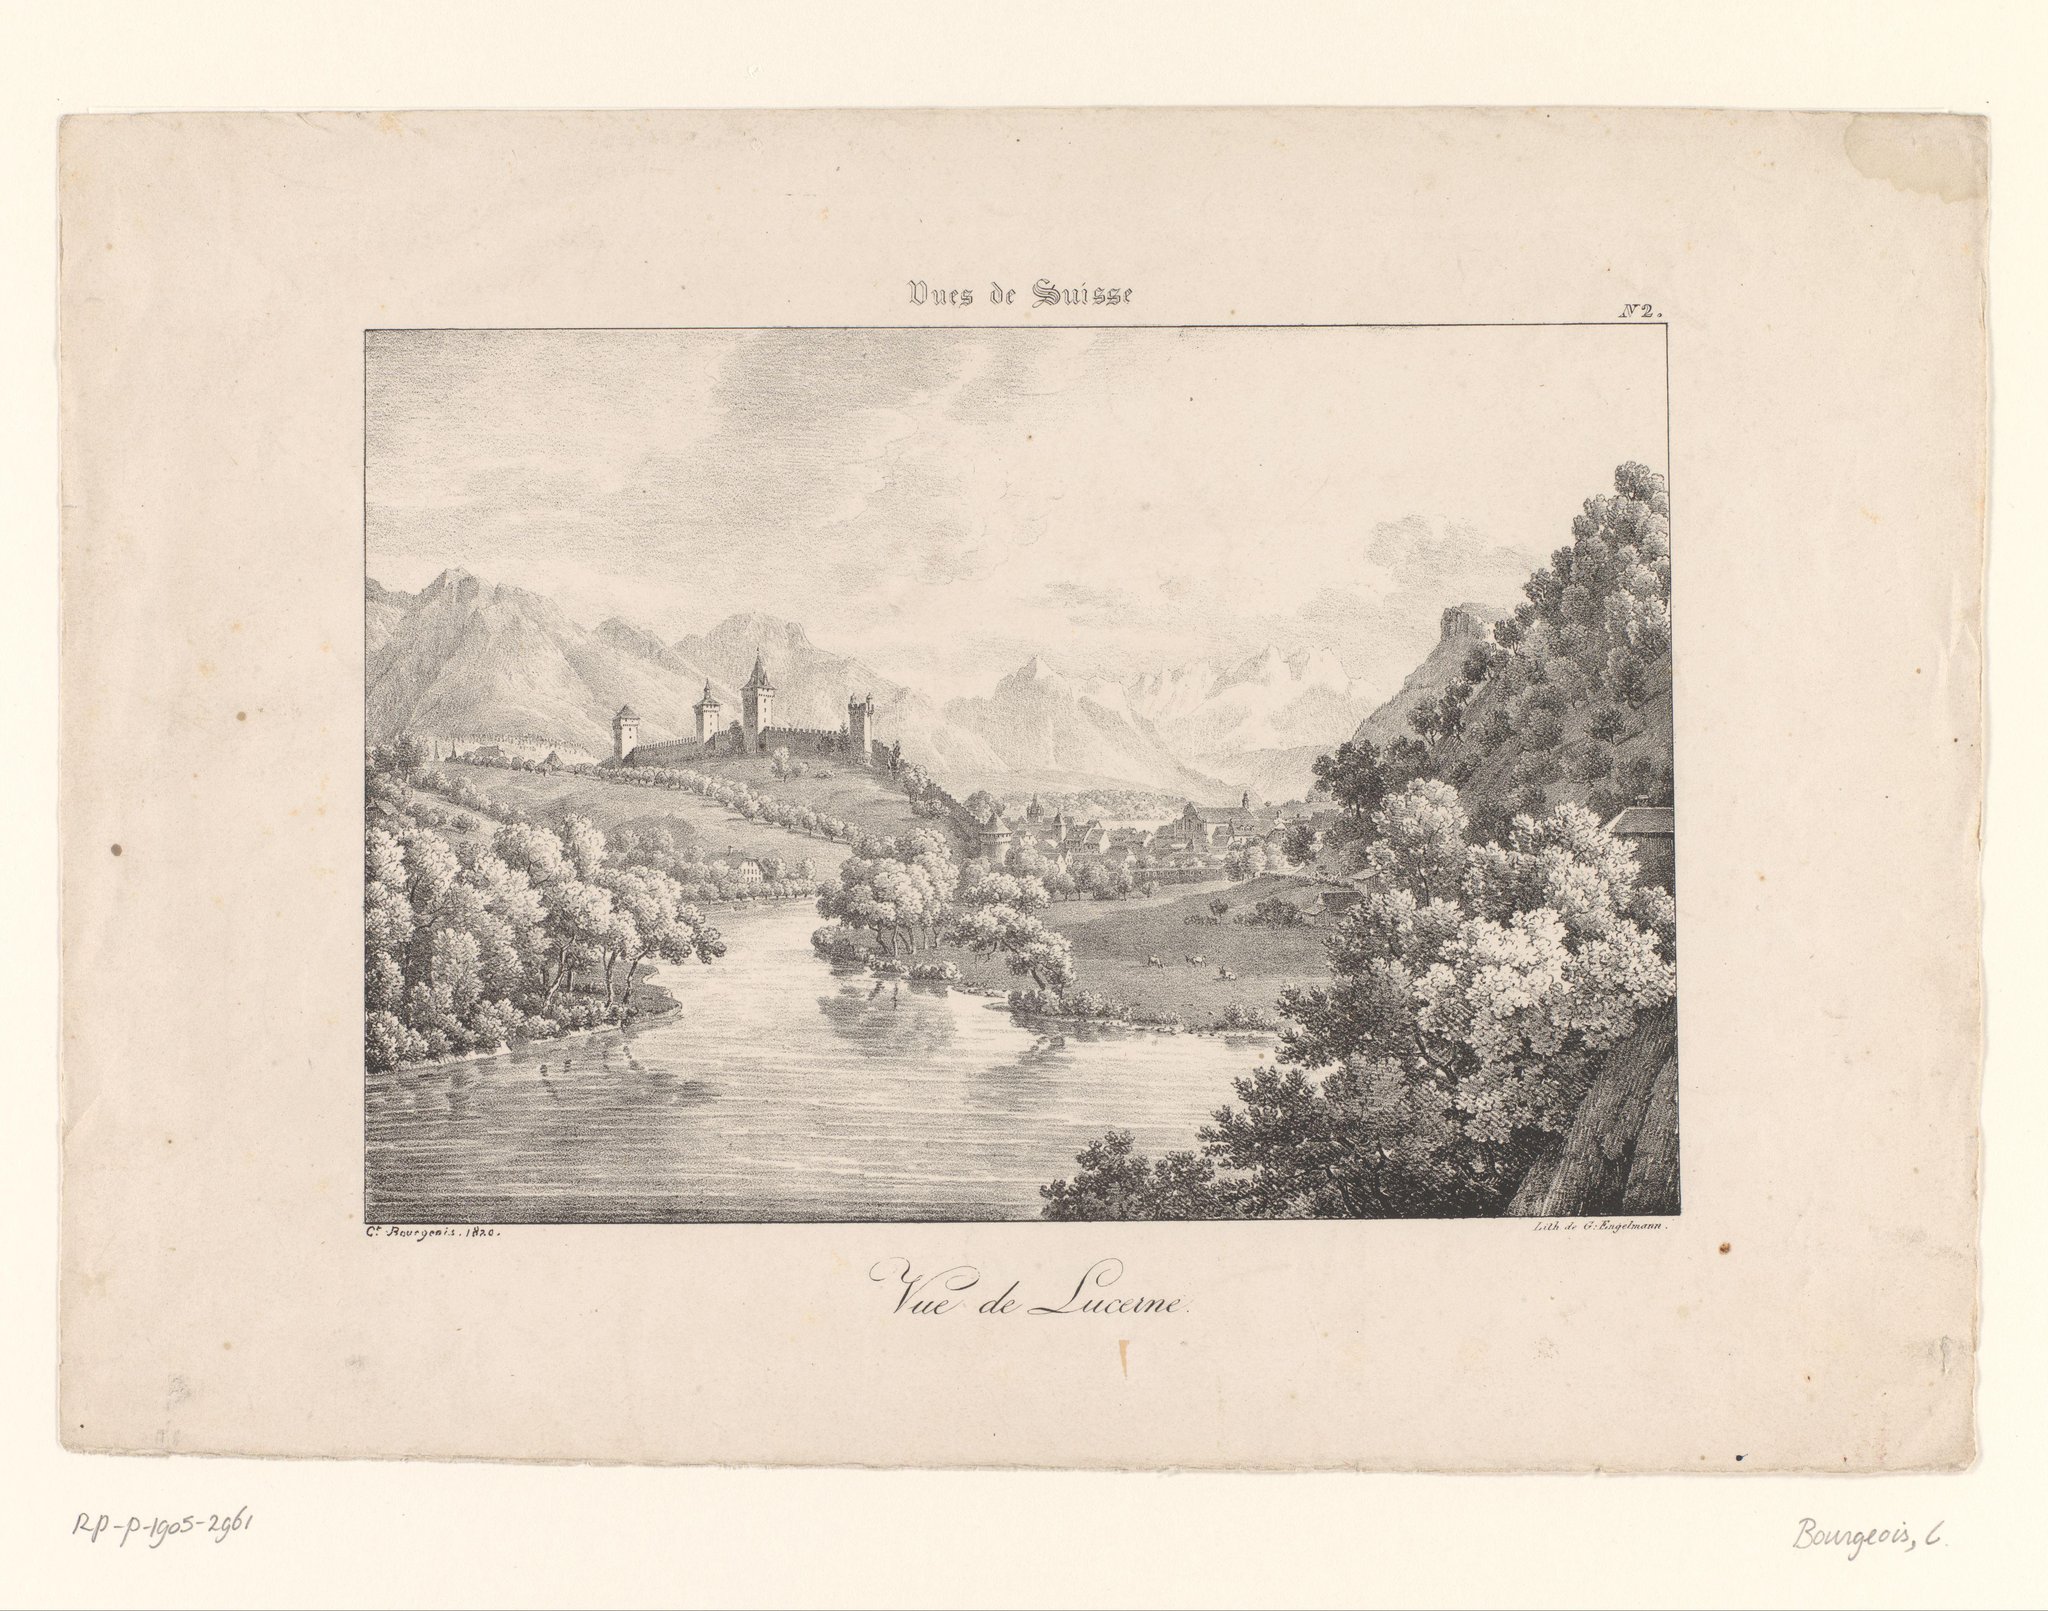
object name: print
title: Zicht op Luzern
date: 1820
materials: paper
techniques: lithograph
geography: paris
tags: prospect of city, town panorama, silhouette of city, mountains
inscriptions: collector's mark: Lugt 2228a